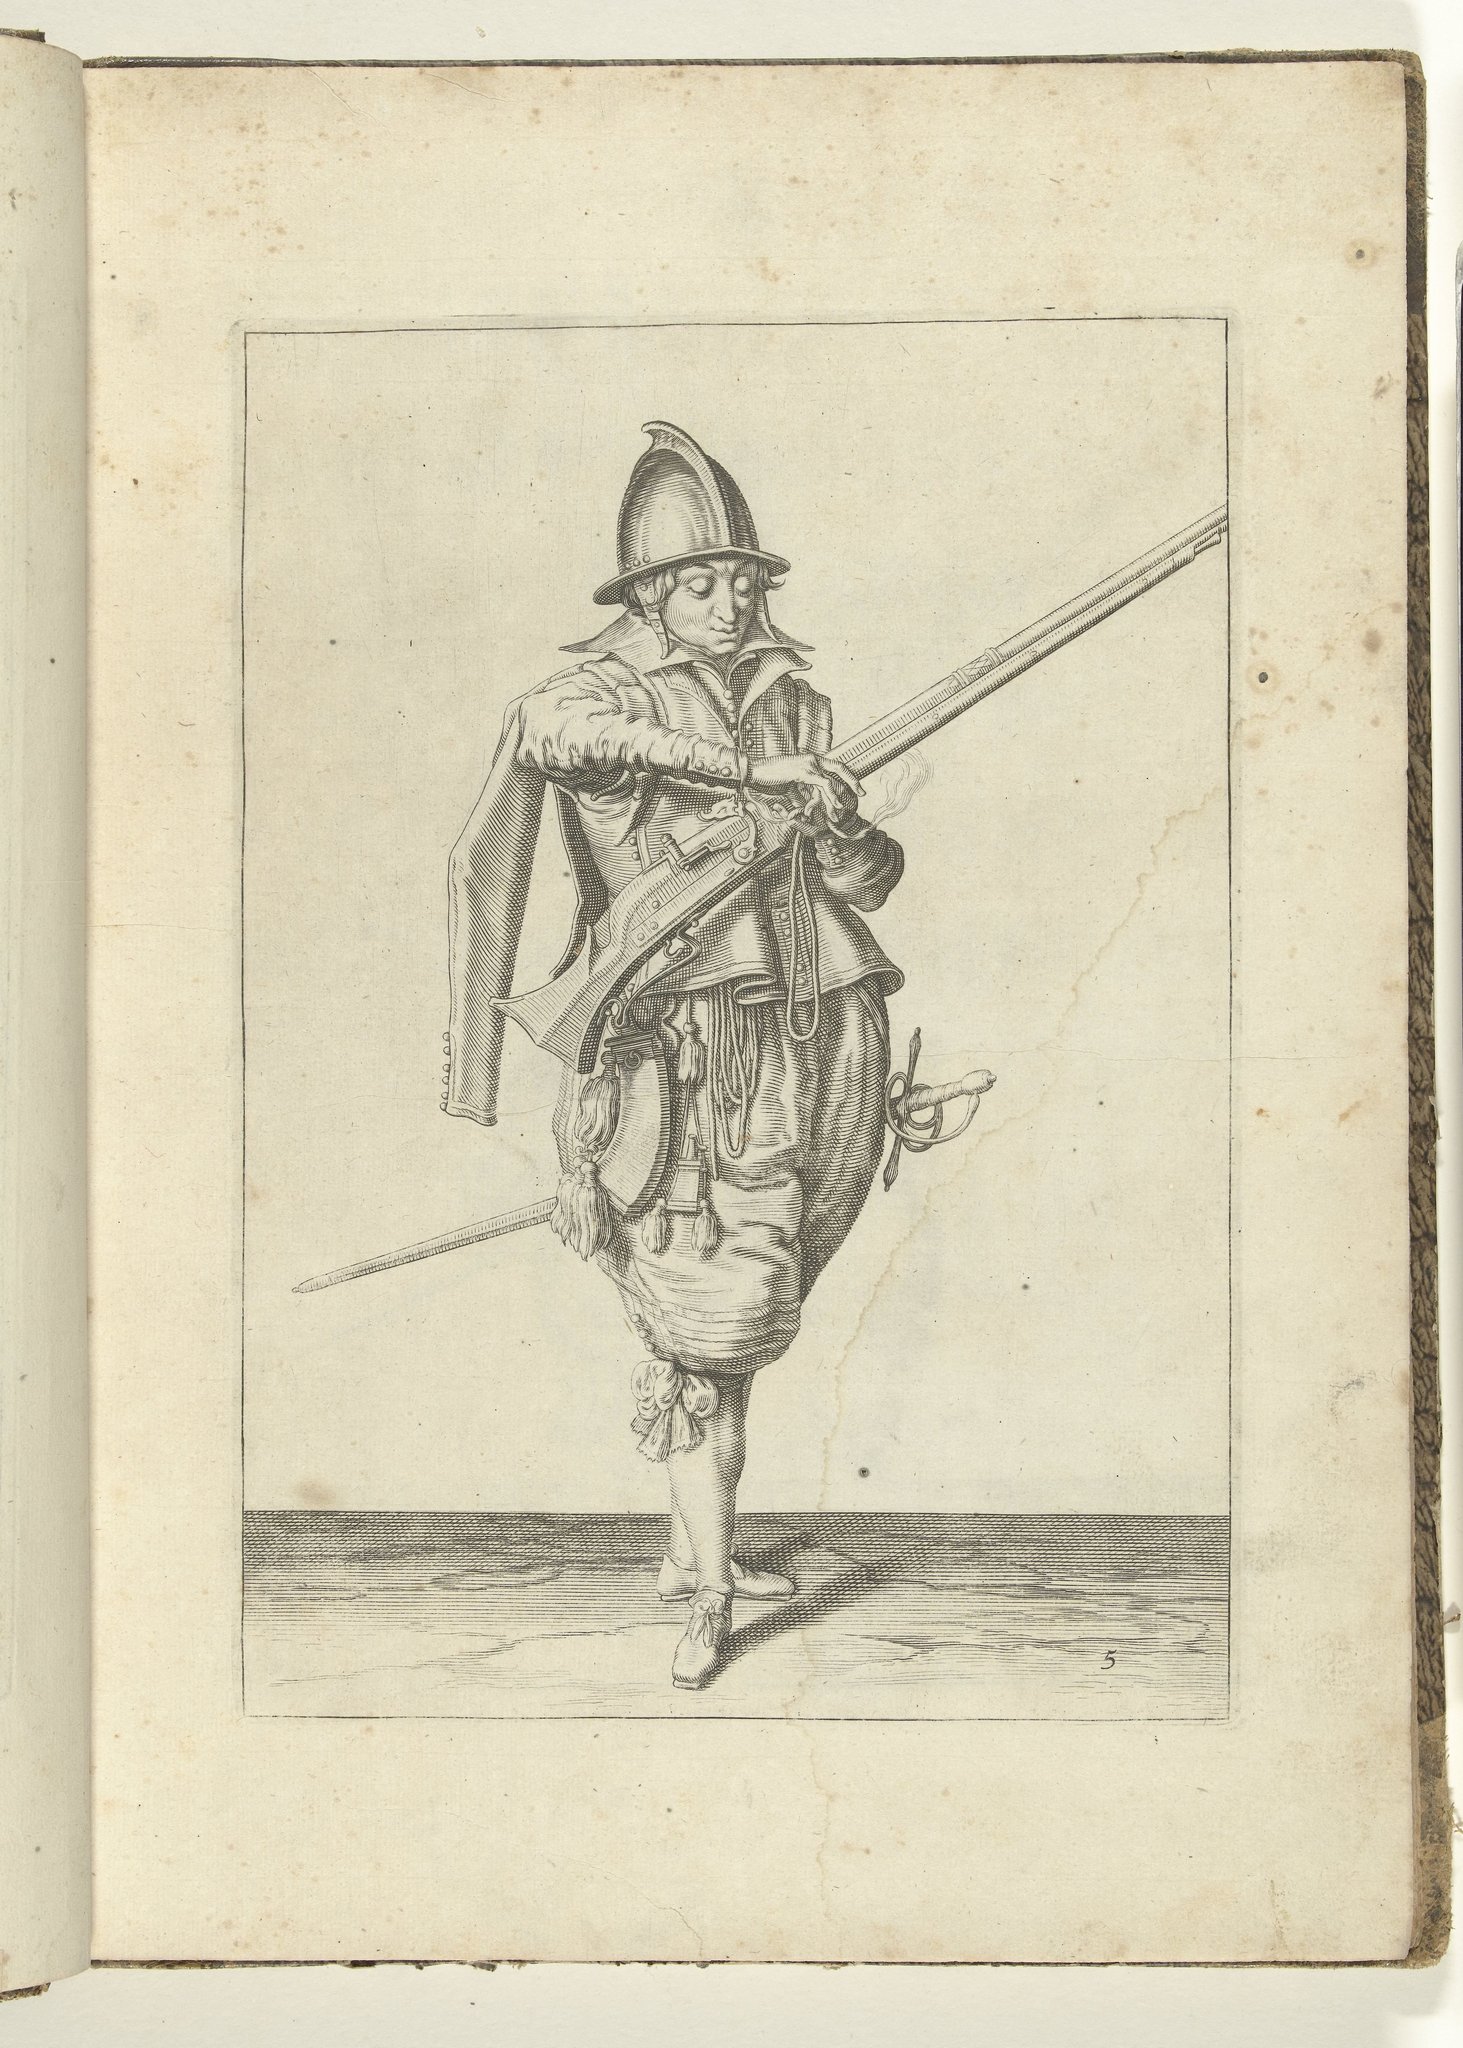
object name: print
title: Soldaat met een roer die zijn lont pakt (nr. 5), ca. 1600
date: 1597-1608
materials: paper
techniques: engraving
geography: amsterdam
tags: the hague, maurice (prince of orange), handling of weapons ~ military training, weapons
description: Een soldaat, ten voeten uit, naar rechts, die een roer (een bepaald type vuurwapen) met zijn linkerhand vasthoudt (nr. 5), ca. 1600. In zijn linkerhand behalve het roer ook een brandende lont. Met zijn rechterhand pakt hij deze lont. Plaat 5 in de instructies voor het hanteren van de roer: Brief enseignement, sur la representation des figures, du droit maniement de l'Harquebuse. Onderdeel van de illustraties in een Franse editie van J. de Gheyns Wapenhandelinghe: J. de Gheyn, Maniement d'armes, d'arquebuses, mousquetz et piques : en conformité de l'ordre de Mour le Prince Maurice, Prince d'Orange, Amsterdam 1608. Krijgswezen rond 1600.